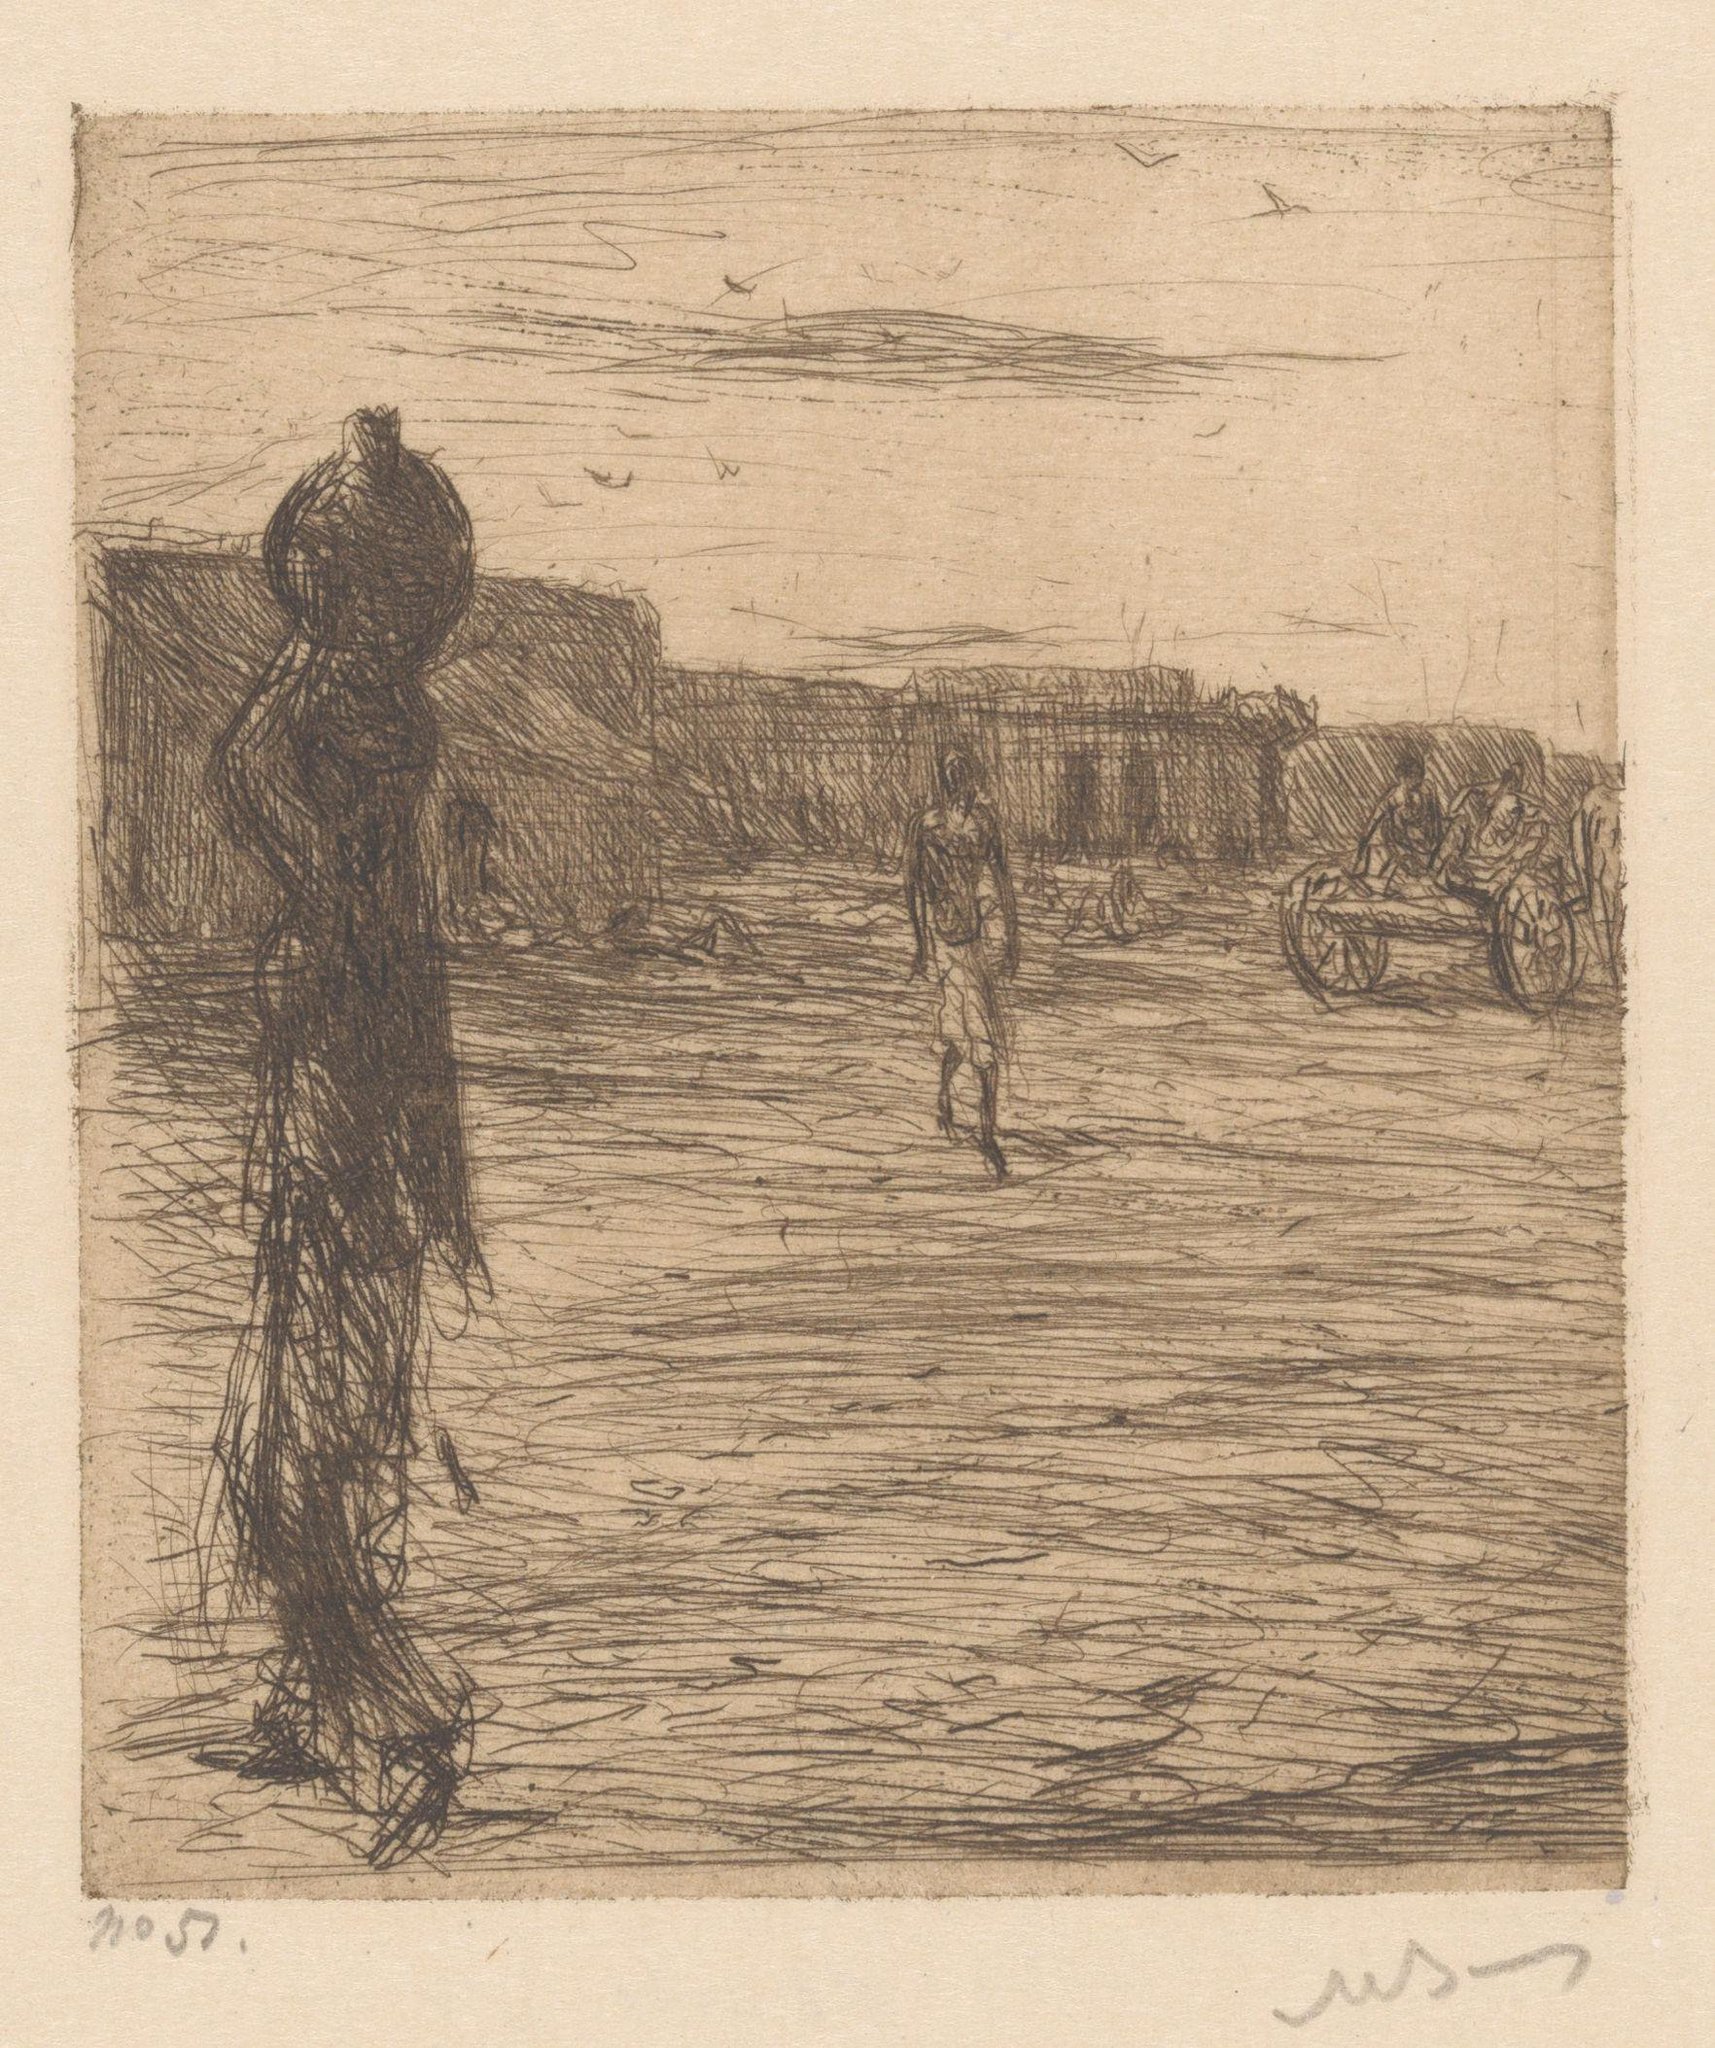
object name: print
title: Straat in Gwalior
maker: marius bauer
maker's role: draughtsman, print maker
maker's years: 1867-1932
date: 1926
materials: paper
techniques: etching, intaglio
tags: container of ceramics: jar, jug, pot, vase, street, carrying something on the head or on the shoulders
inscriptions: collector's mark: Lugt 2228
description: Een figuur met een kruik op het hoofd wandelt over straat in Gwalior in Brits-Indië. Op de achtergrond zitten twee figuren op een kar die gespannen is achter een trekdier.